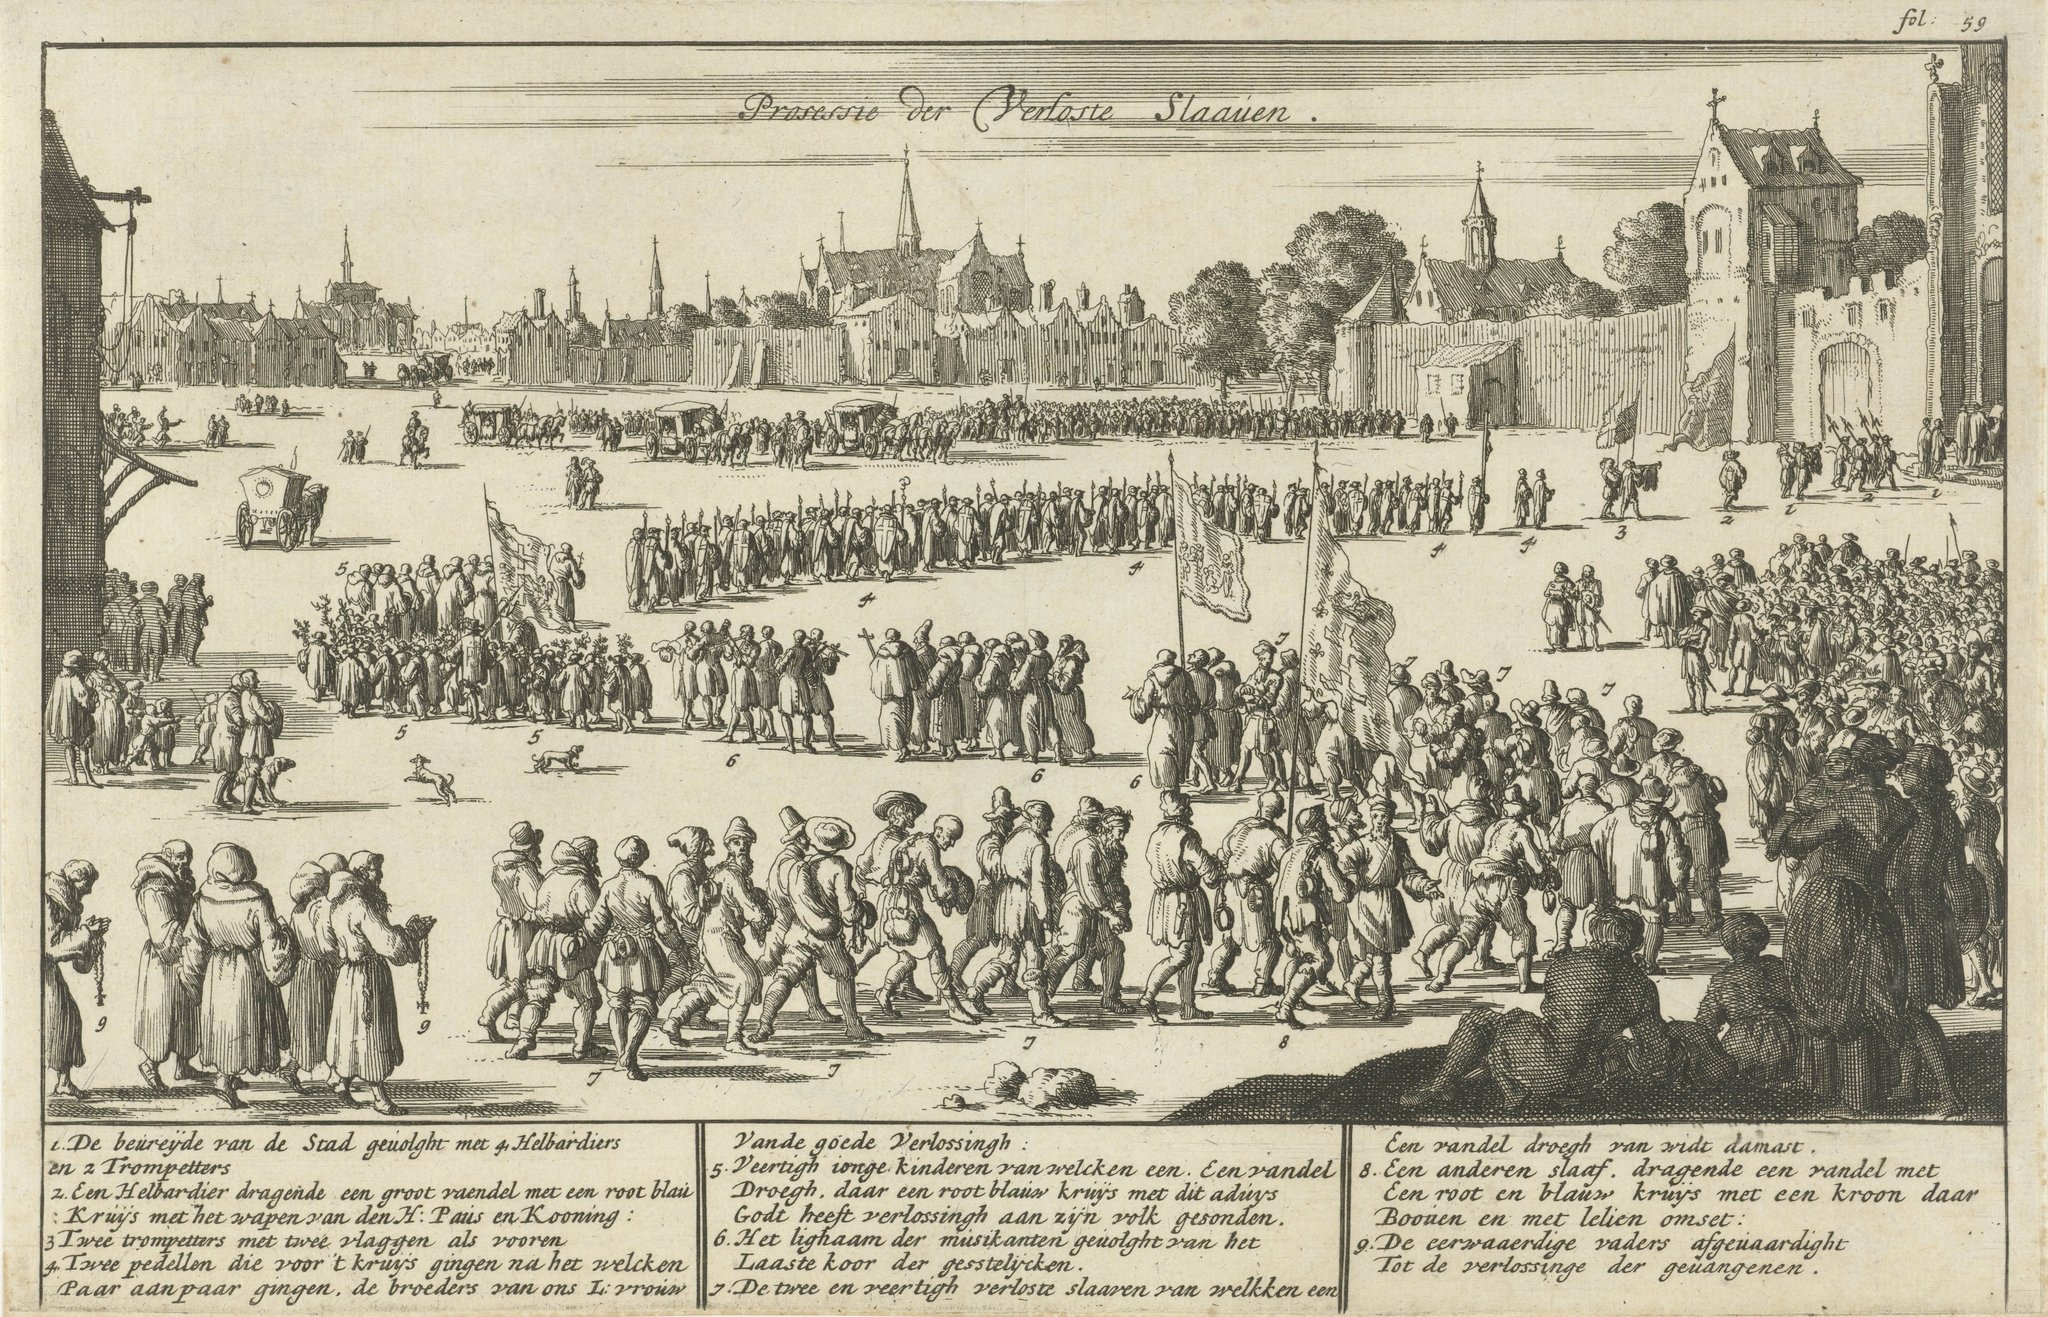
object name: print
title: Prosessie der Verloste Slaaven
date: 1684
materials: paper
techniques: engraving, etching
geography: amsterdam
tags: freedom ~ slavery, procession ~ christian religion, paris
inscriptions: collector's mark: Lugt 2228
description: 42 Franse mannen, die in Tunis in slavernij verkeerden, zijn daar vrijgekocht door de Orde der Trinitariërs. Dergelijke slaafgemaakten stonden bekend als 'christenslaven'. Ter ere van hun vrijkoping worden ze in Parijs in een processie door de stad gevoerd. In het onderschrift de legenda 1-9. Rechtsboven genummerd: fol: 59.